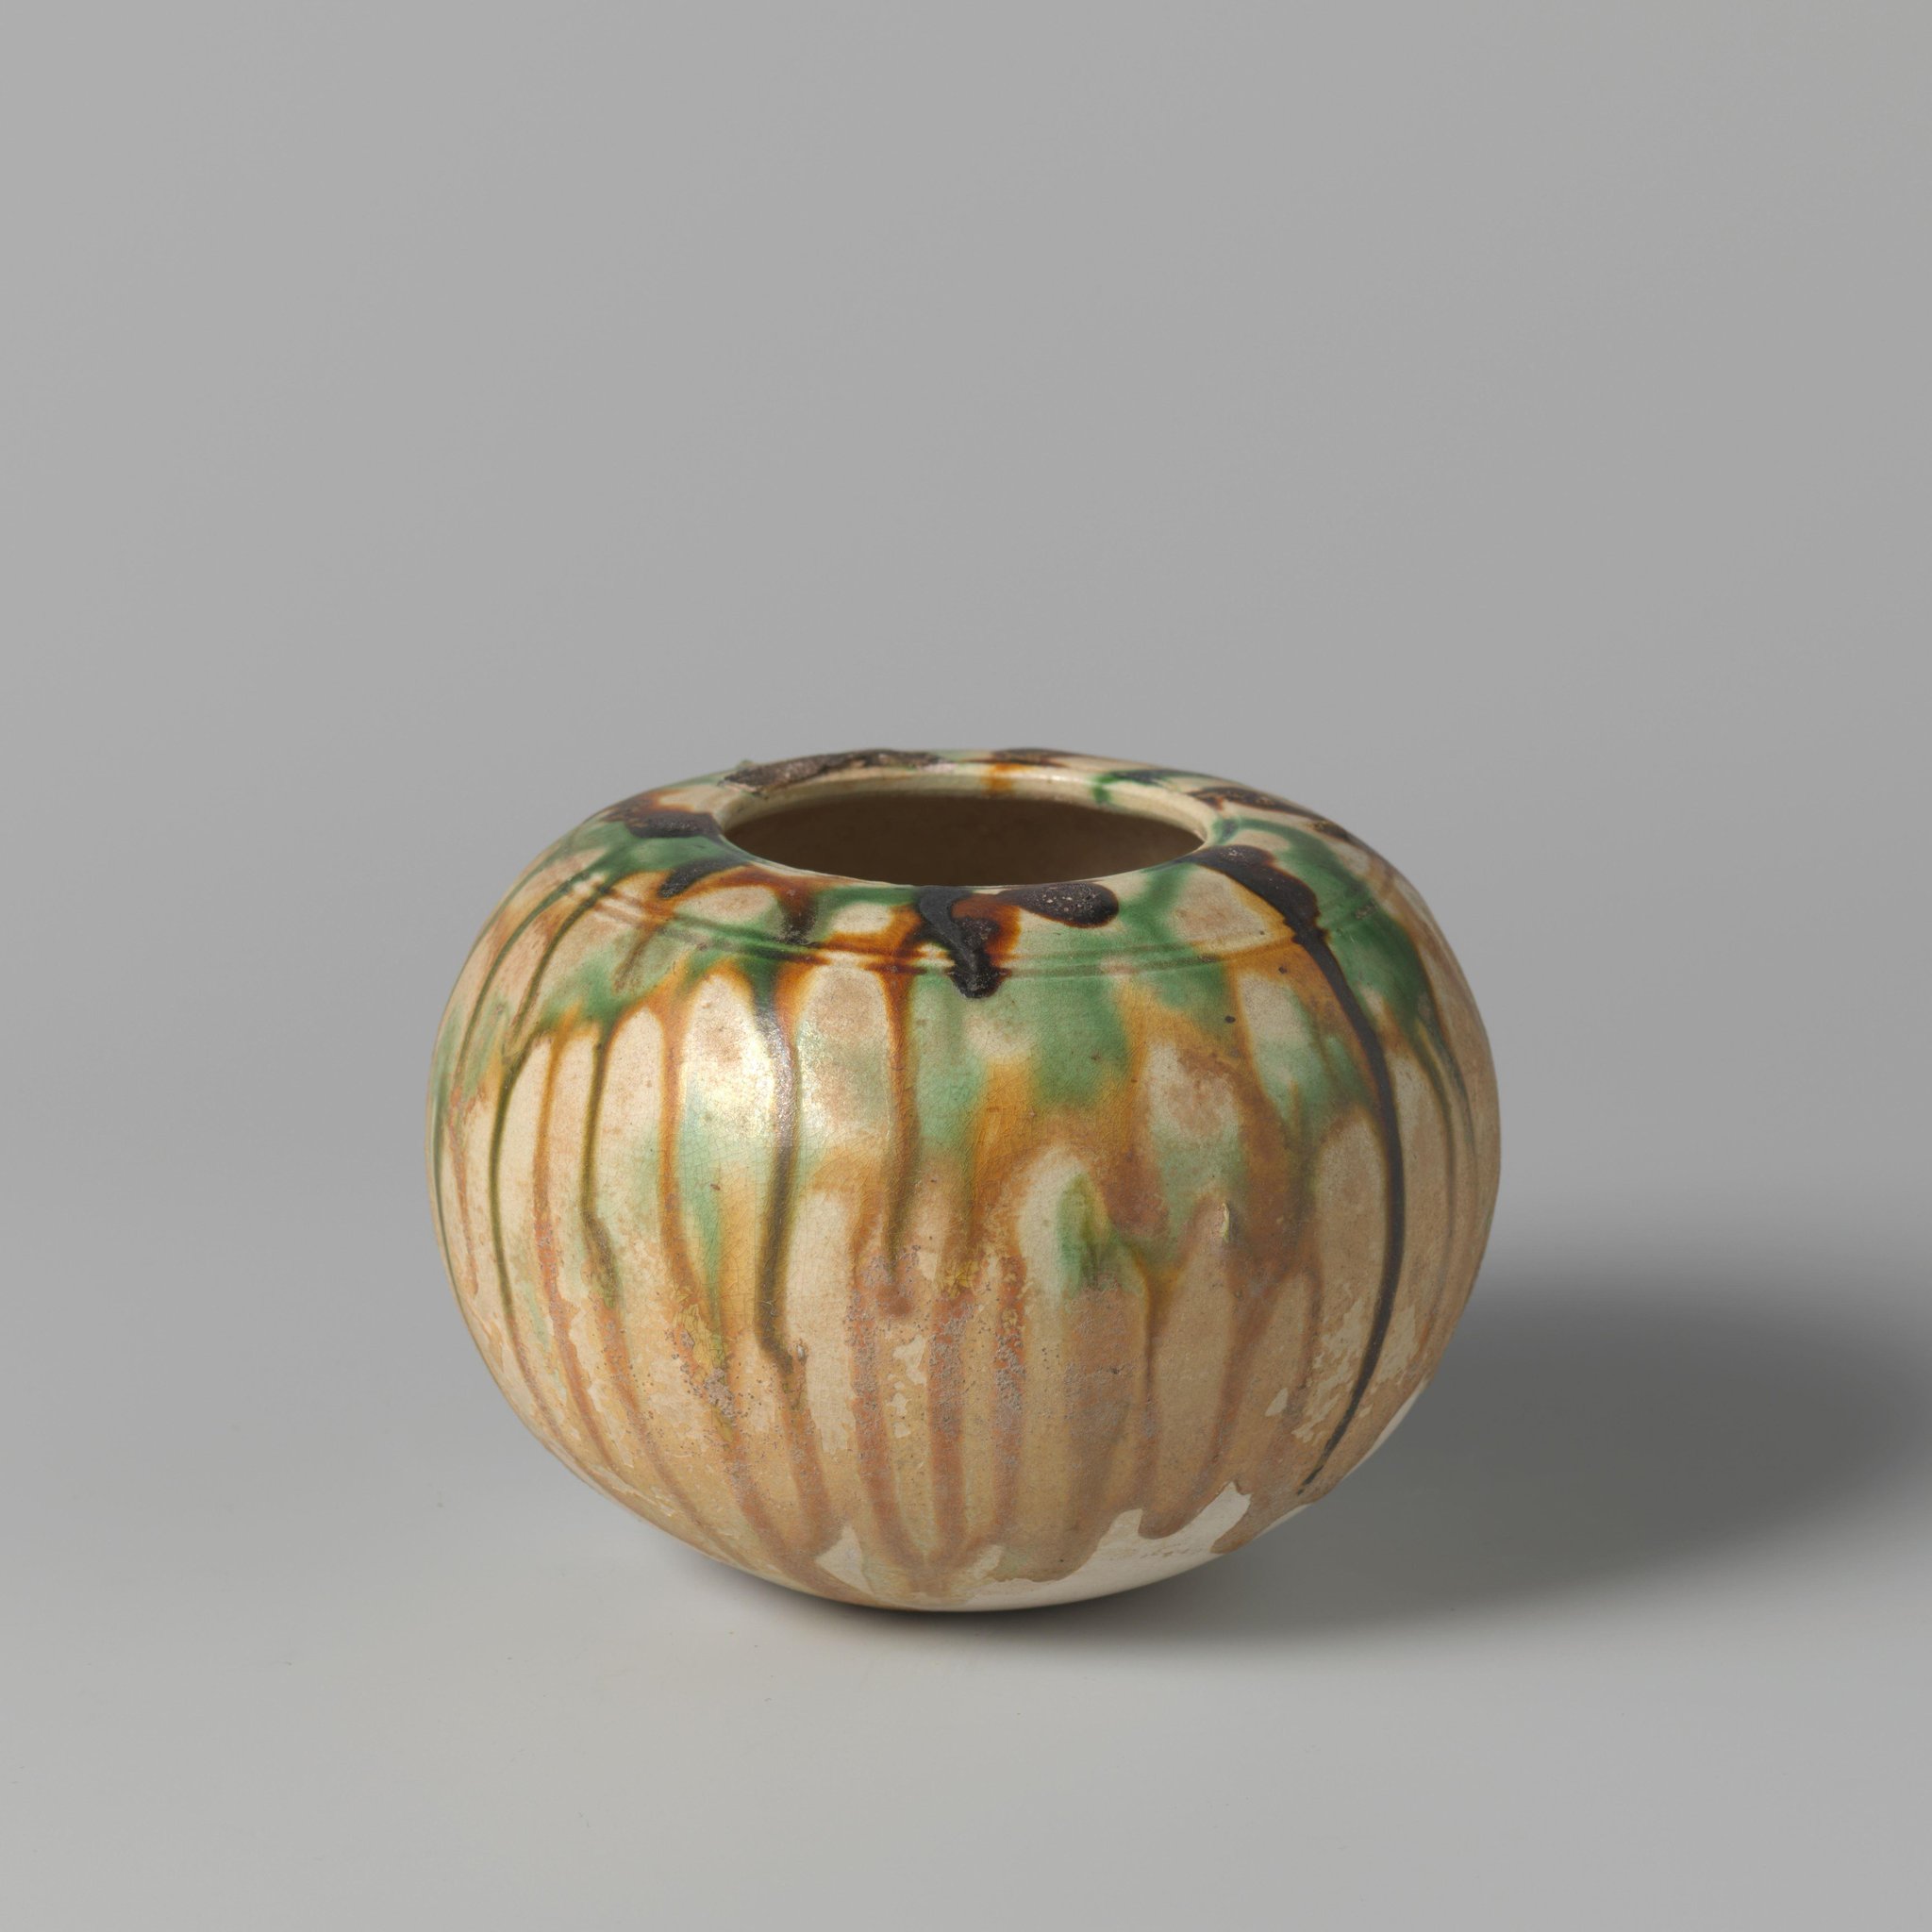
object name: pot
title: Covered jar with a three-colored glaze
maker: Anonymous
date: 618-906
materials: earthenware, glaze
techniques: firing, turning, vitrification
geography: china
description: Dekselpot van aardewerk met een bolvormig lichaam, bedekt met een groen, bruin en crèmekleurig glazuur. Sancai, Tang.